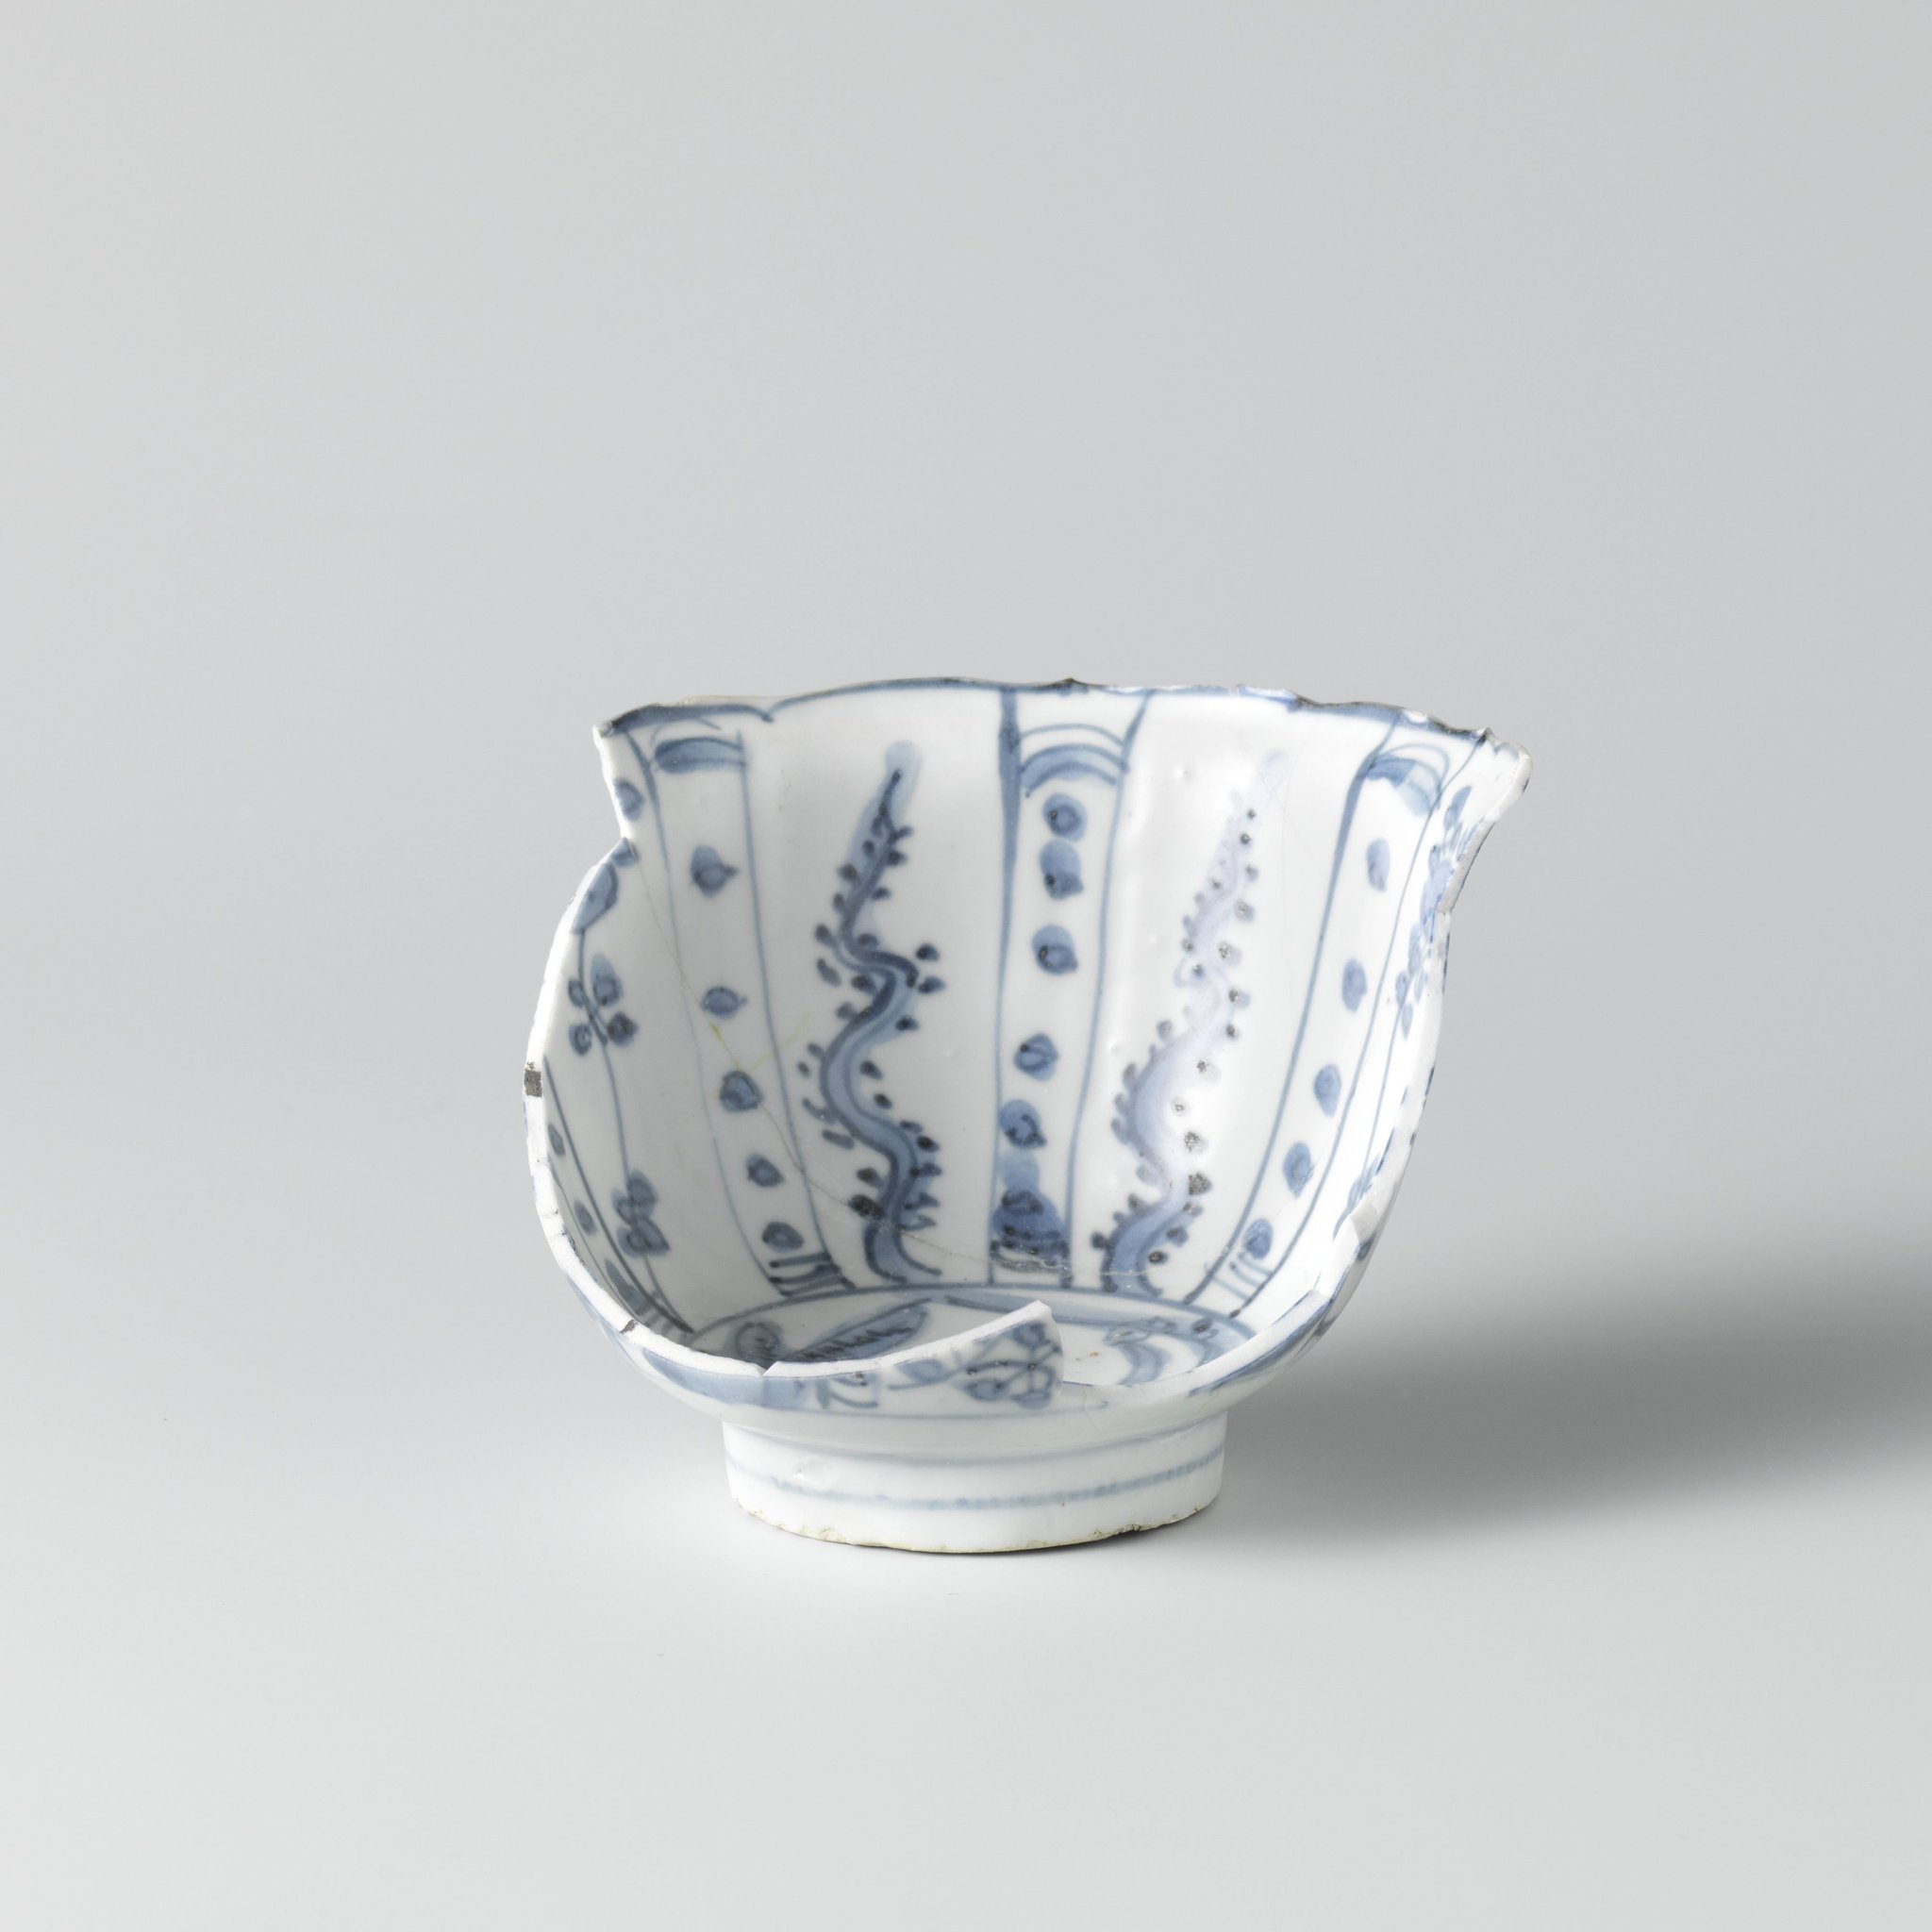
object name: kraaikop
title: Kom uit V.O.C.-schip de 'Witte Leeuw'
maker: Anonymous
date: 1613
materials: bone china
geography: jingdezhen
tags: verenigde oostindische compagnie, sint-helena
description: A high bowl. The interior panels decorated with peach-sprays and thorny branches. The exterior with flower- and fruit-sprays, bamboo and a bird.